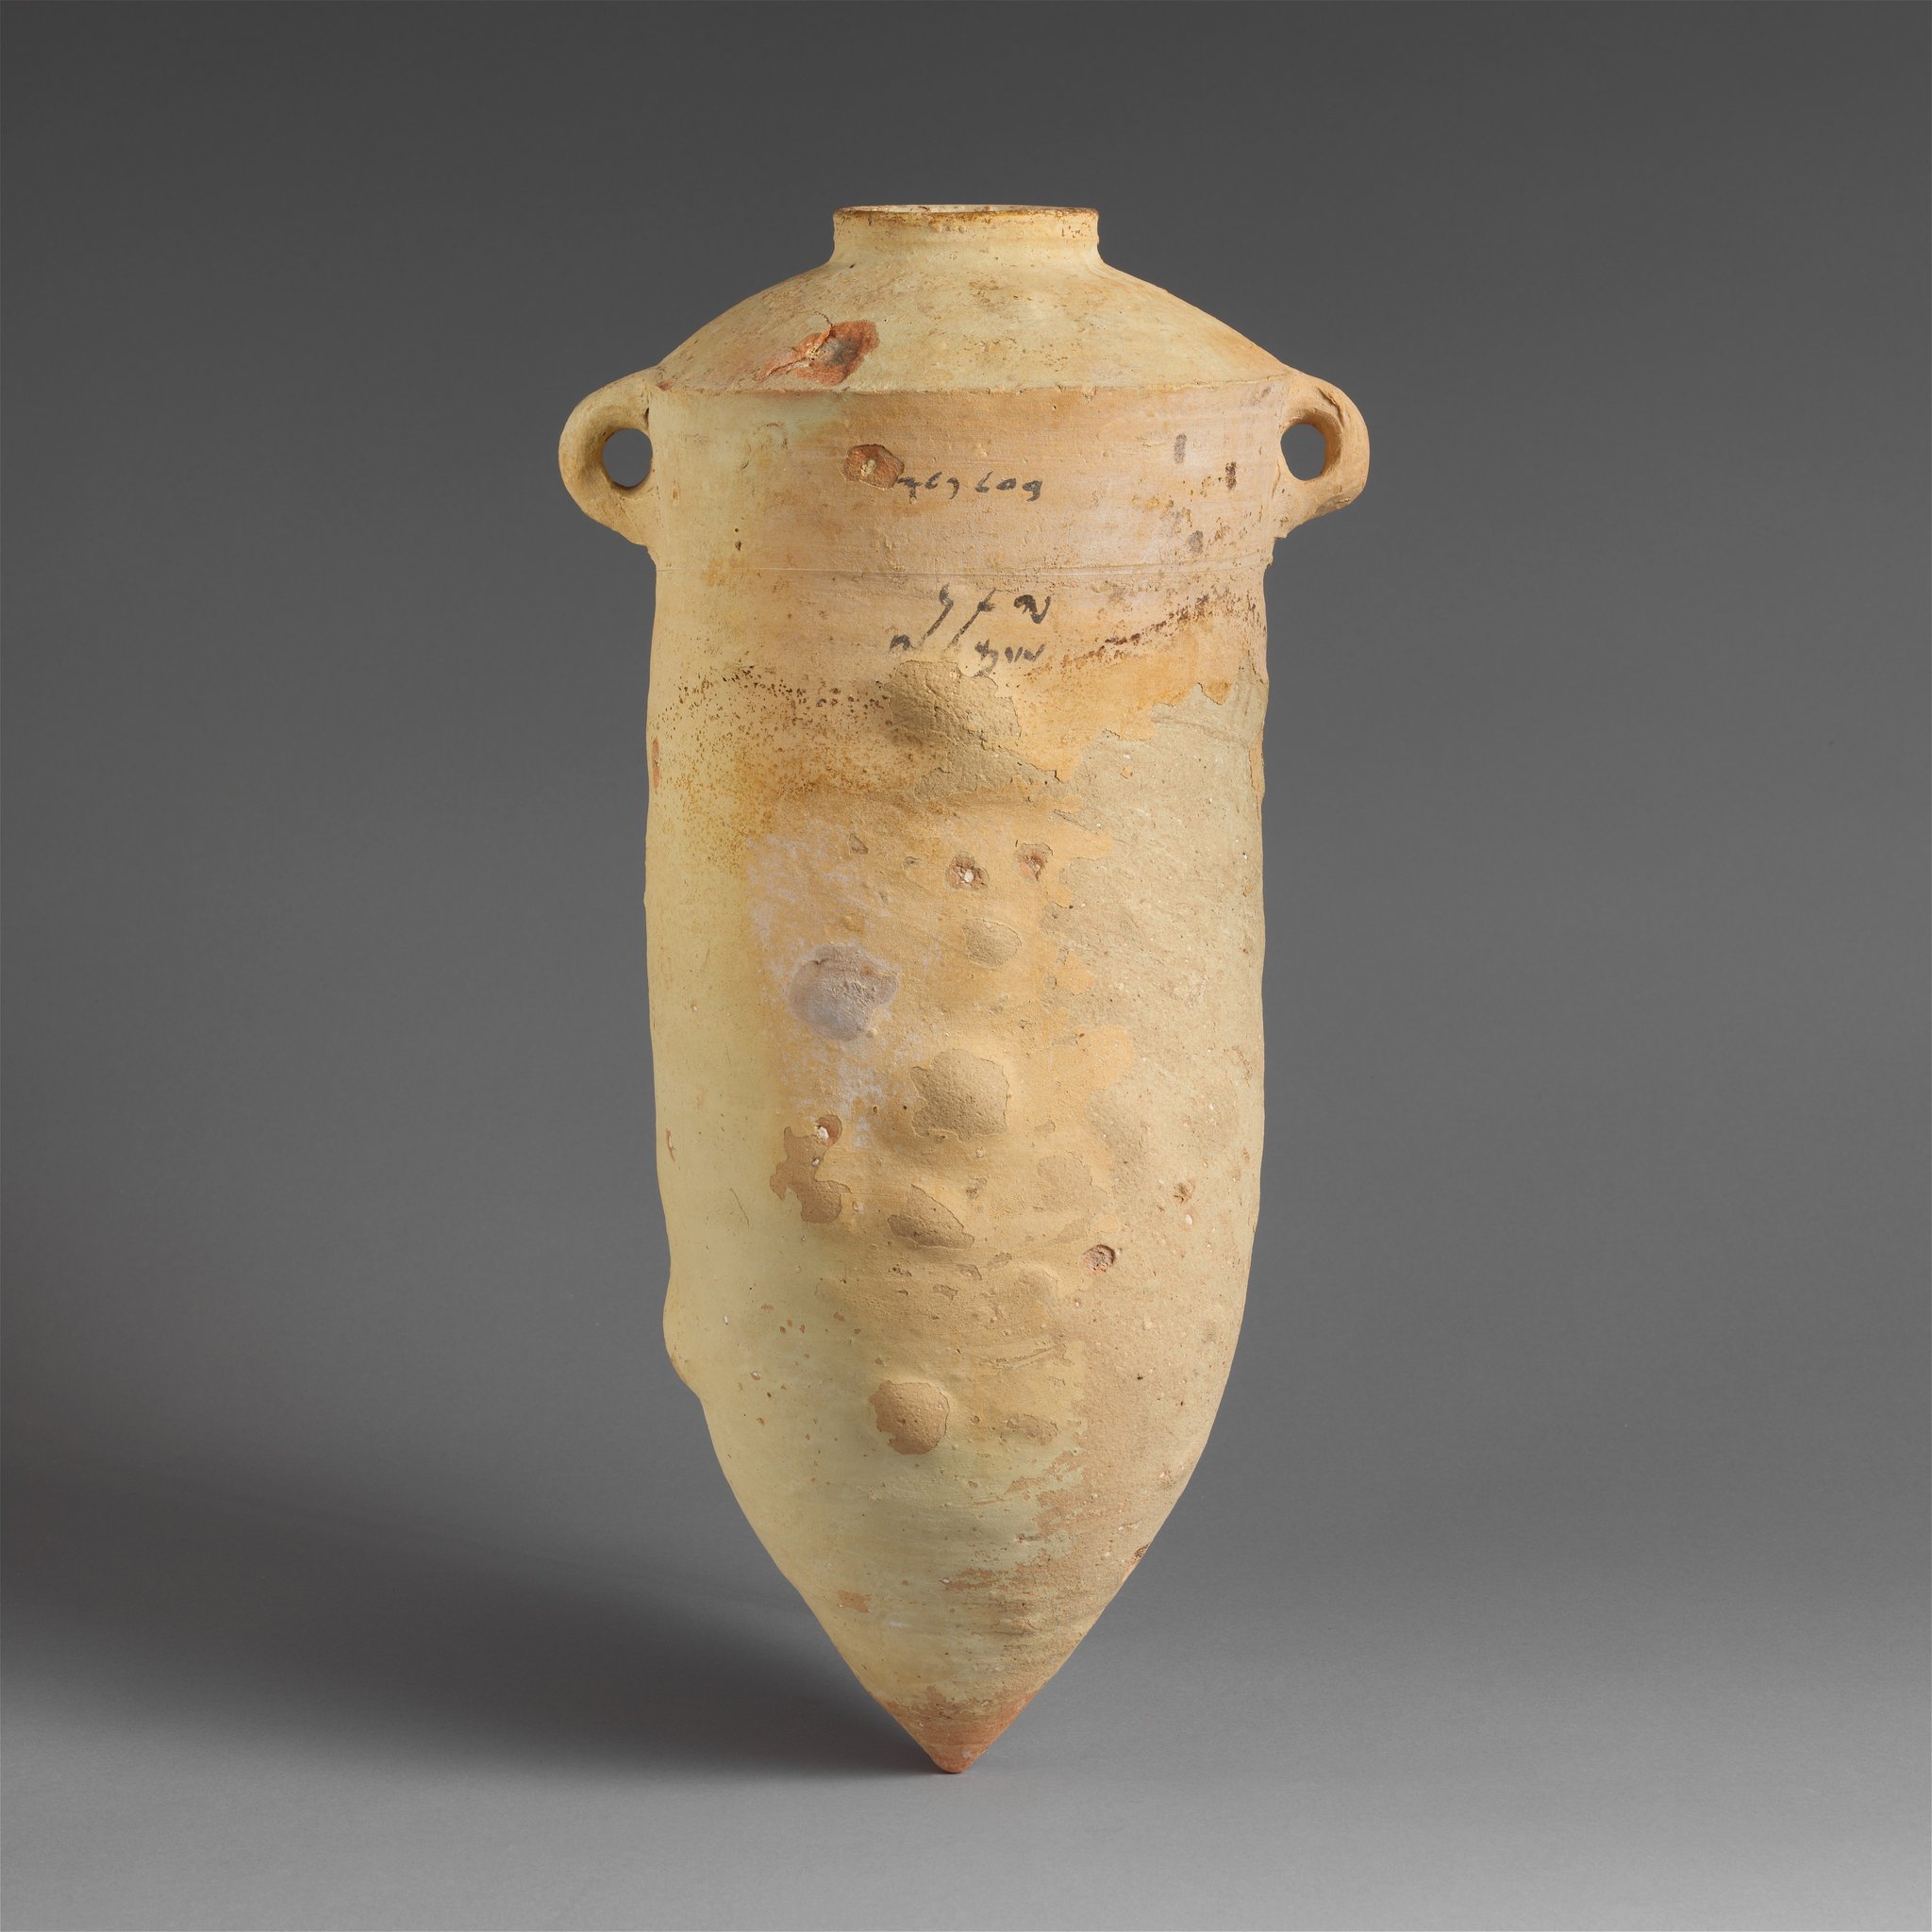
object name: amphora with phoenician inscription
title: Terracotta amphora with Phoenician inscription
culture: cypriot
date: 600-401 BCE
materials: clay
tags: phoenician